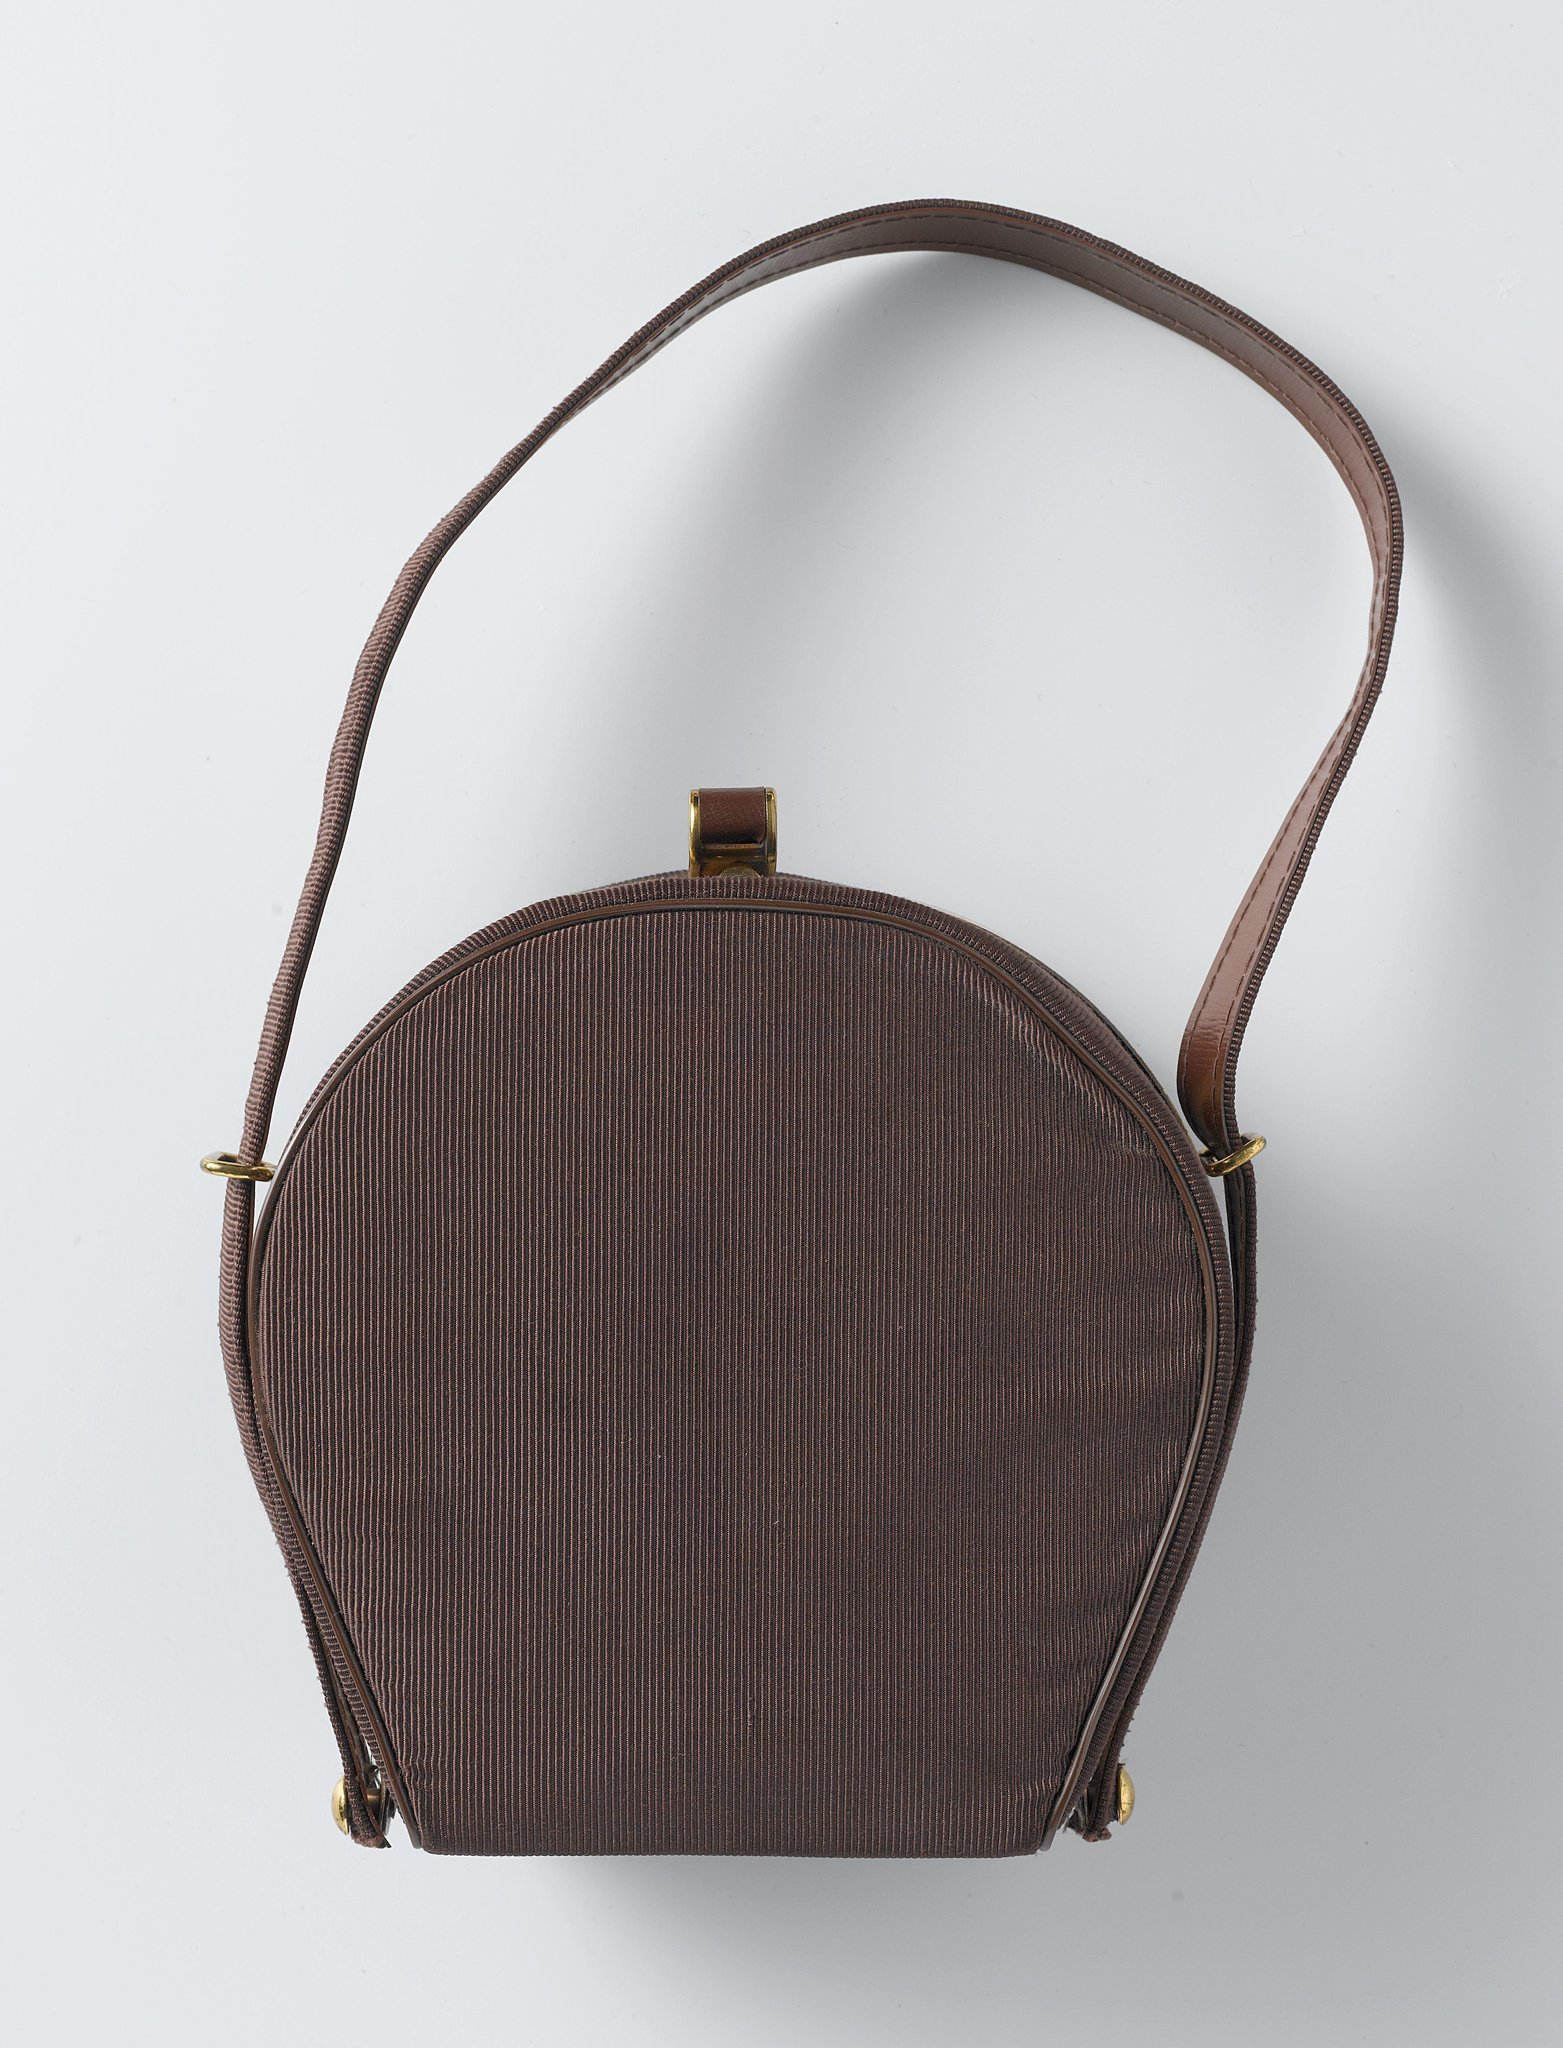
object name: handbag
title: Handtas van donkerbruine ripszijde in hoefijzervorm met knipsluiting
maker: Anonymous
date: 1950-1960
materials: metal, plastic, silk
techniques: forging, weave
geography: netherlands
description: Handtas van donkerbruine ripszijde in een hoefijzervorm. De randen zijn afgezet met een bruin kunststof bies, en waar de tas sluit met een goudkleurige metalen strip. Bovenop een knipsluiting. Langs de zijkant van de tas een hengsel van bruin ripszijde, genaaid op een strook bruin kunststof. Het begin en eind van het hengsel is door middel van goudkleurige pinnen vastgezet aan de zijkant van de tas. De binnenkant is met verstevigd bruinkleurige polyester gevoerd, waar aan een kant een vakje dat is afgezet met een bruin kunststof bies.